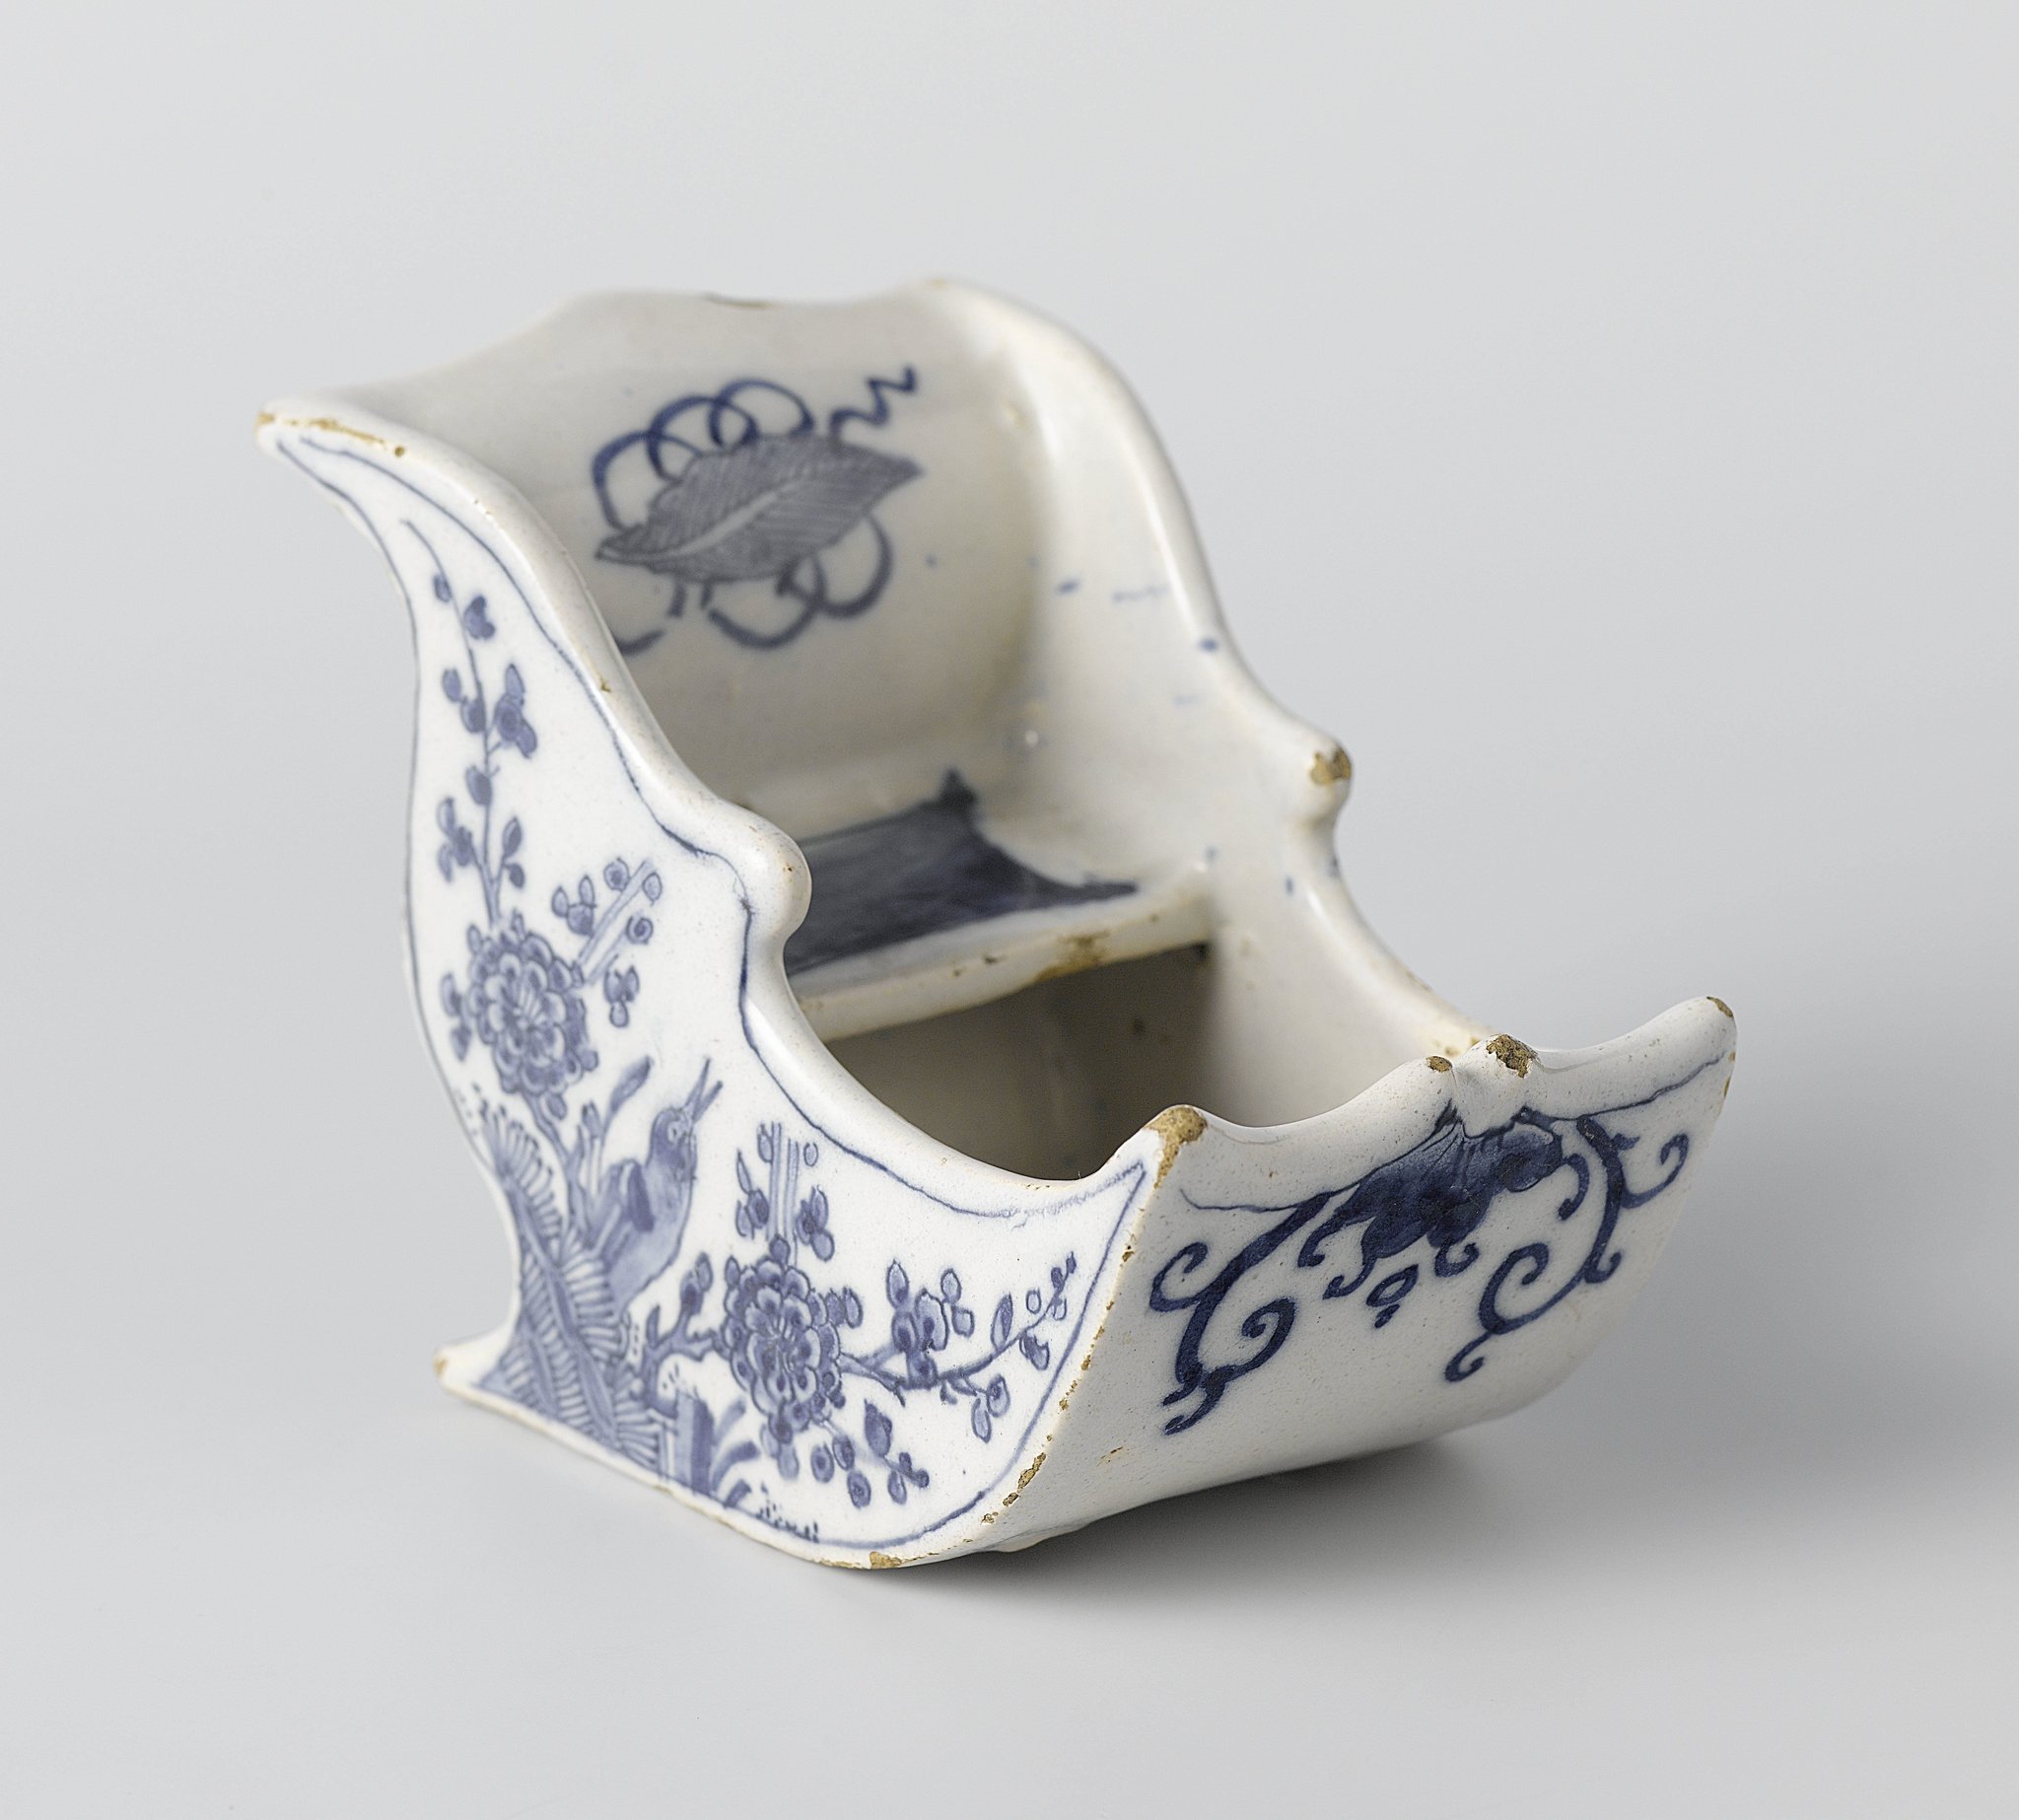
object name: container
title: Slee van faience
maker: Anonymous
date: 1750-1775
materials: faience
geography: delft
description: Slee van faience. Blauw beschilderd. Vier gaten in de bodem.